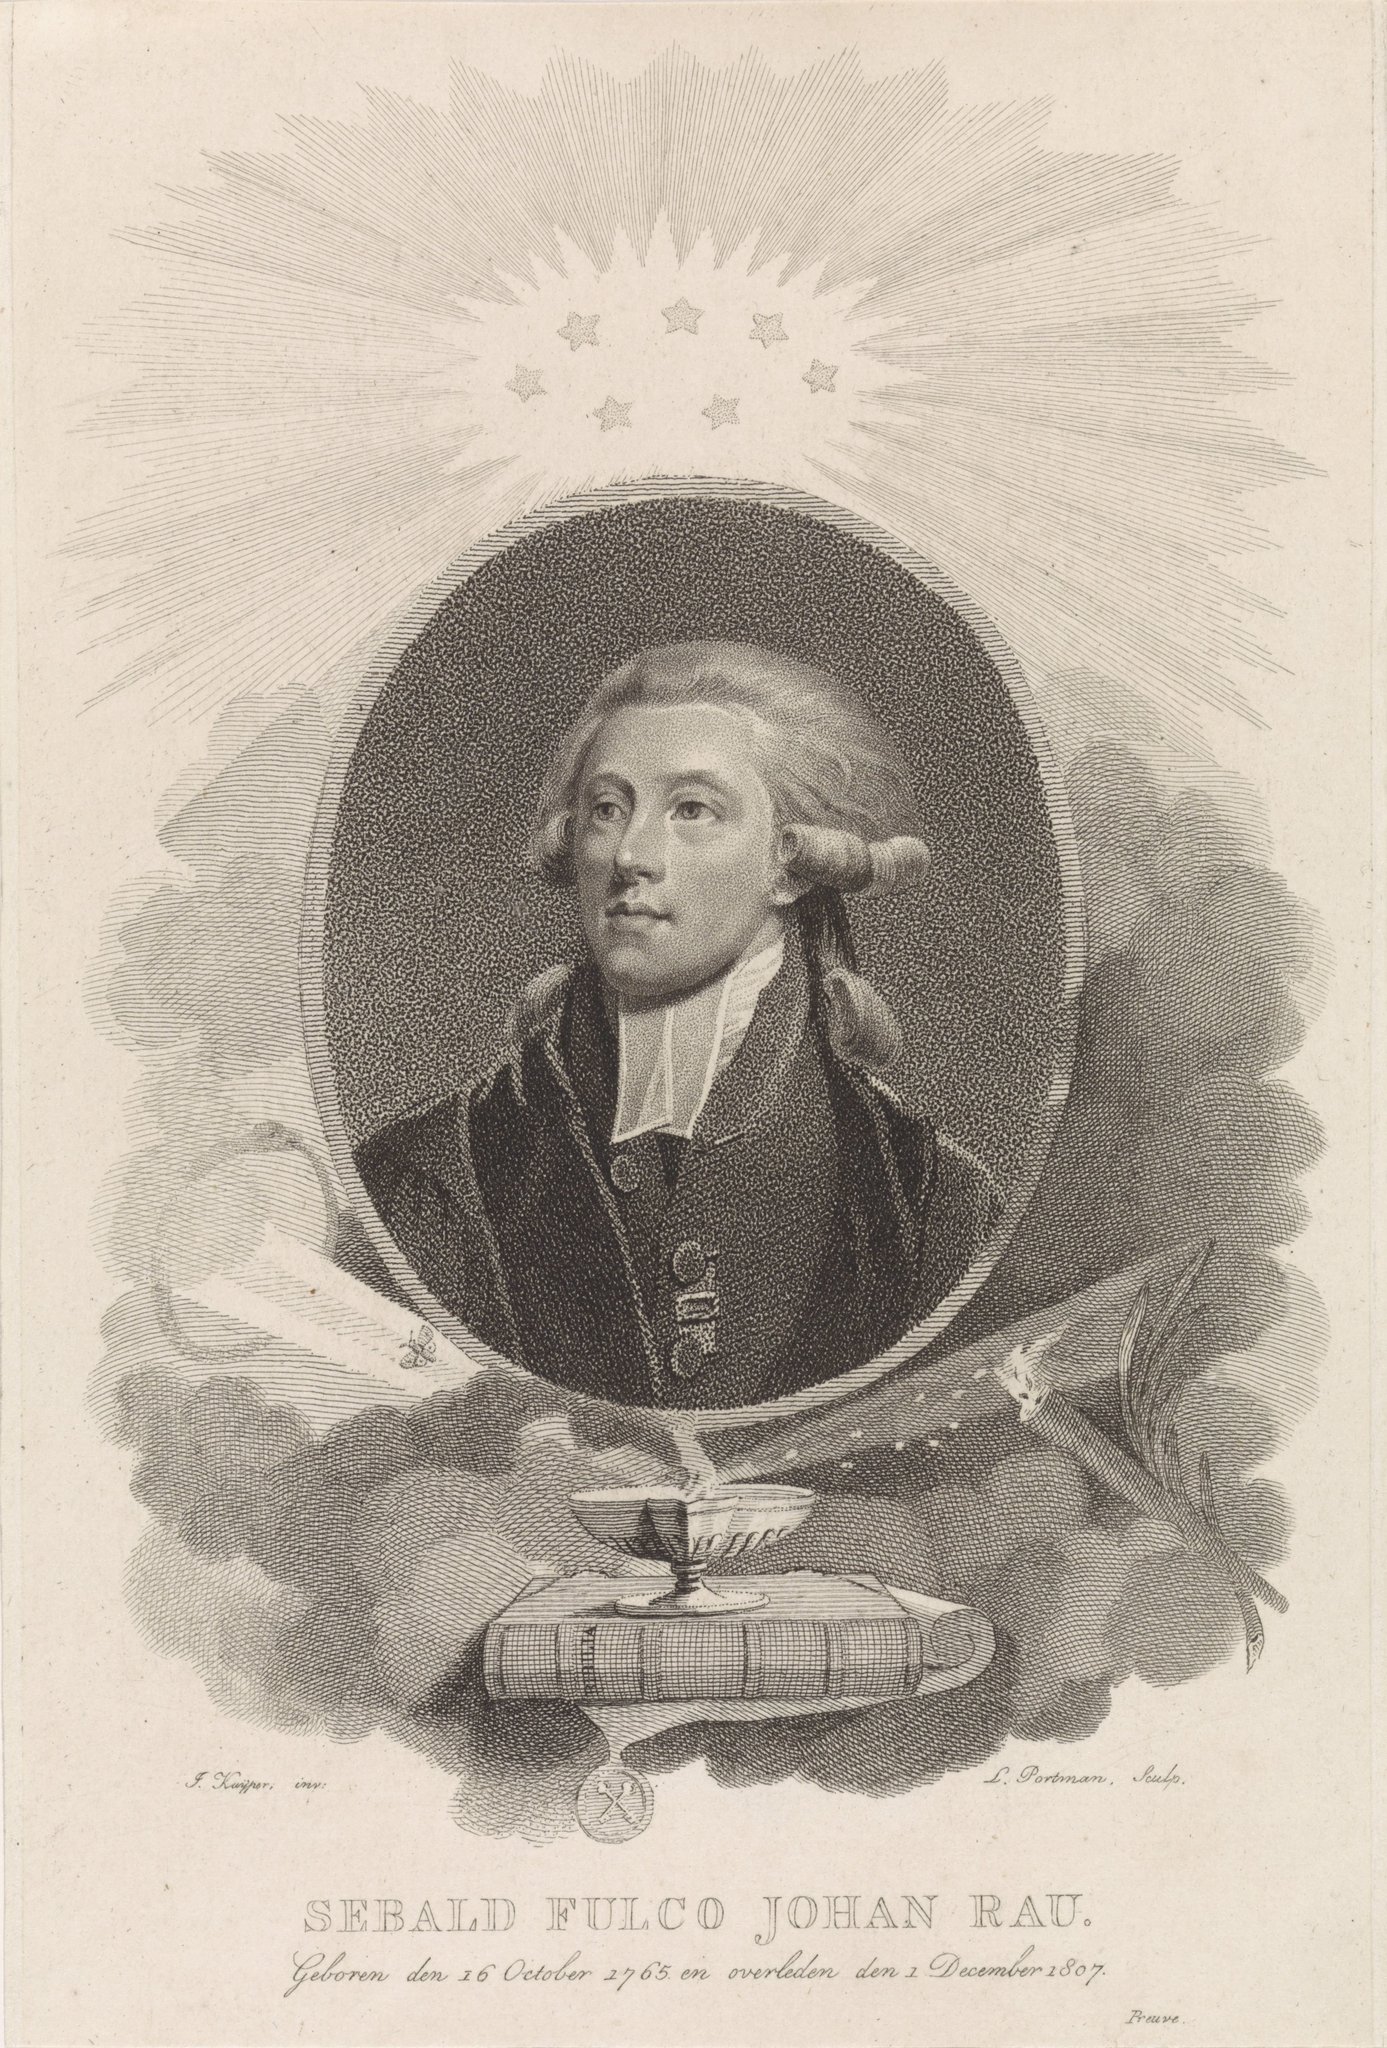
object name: print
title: Allegorisch portret van de hoogleraar Sebald Fulco Johan Rau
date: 1807-1828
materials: paper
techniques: etching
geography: amsterdam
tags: leiden, truth; 'verità' (ripa) (+ symbolical representation of concept), torch, light, insects: butterfly (+ animals used symbolically), honour, glory; 'ampiezza della gloria', 'gloria', 'gloria de prencipi', 'gloria & honore', 'honore', 'sublimatà della gloria' (ripa) (+ symbolical representation of concept), oil-lamp, serpent ouroboros, darkness, the bible as a book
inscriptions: collector's mark: Lugt 2228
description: Portret van Sebald Fulco Johan Rau. Onder zijn portret een brief, de bijbel en een lamp. Links in het licht een vlinder die naar de slang vliegt, een verwijzing naar de onsterfelijkheid van de ziel van de geportretteerde. Rechts in het duister een fakkel en een palmtak, symbool van de waarheid. Het portret is bekroond met een krans van sterren, als symbool voor eeuwige Heerlijkheid.